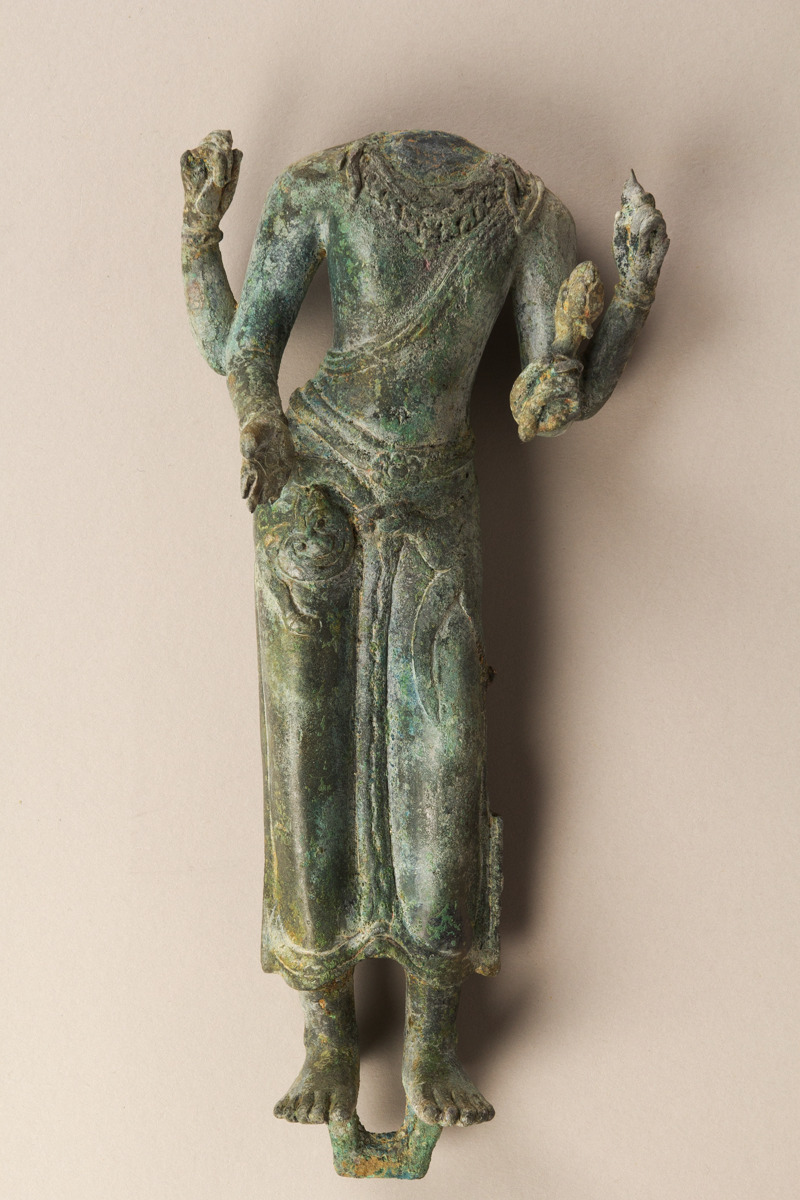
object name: figure fragment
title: Fragment of a Standing Avalokiteshvara or Shiva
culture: indonesian, kalimantan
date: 701-800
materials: bronze